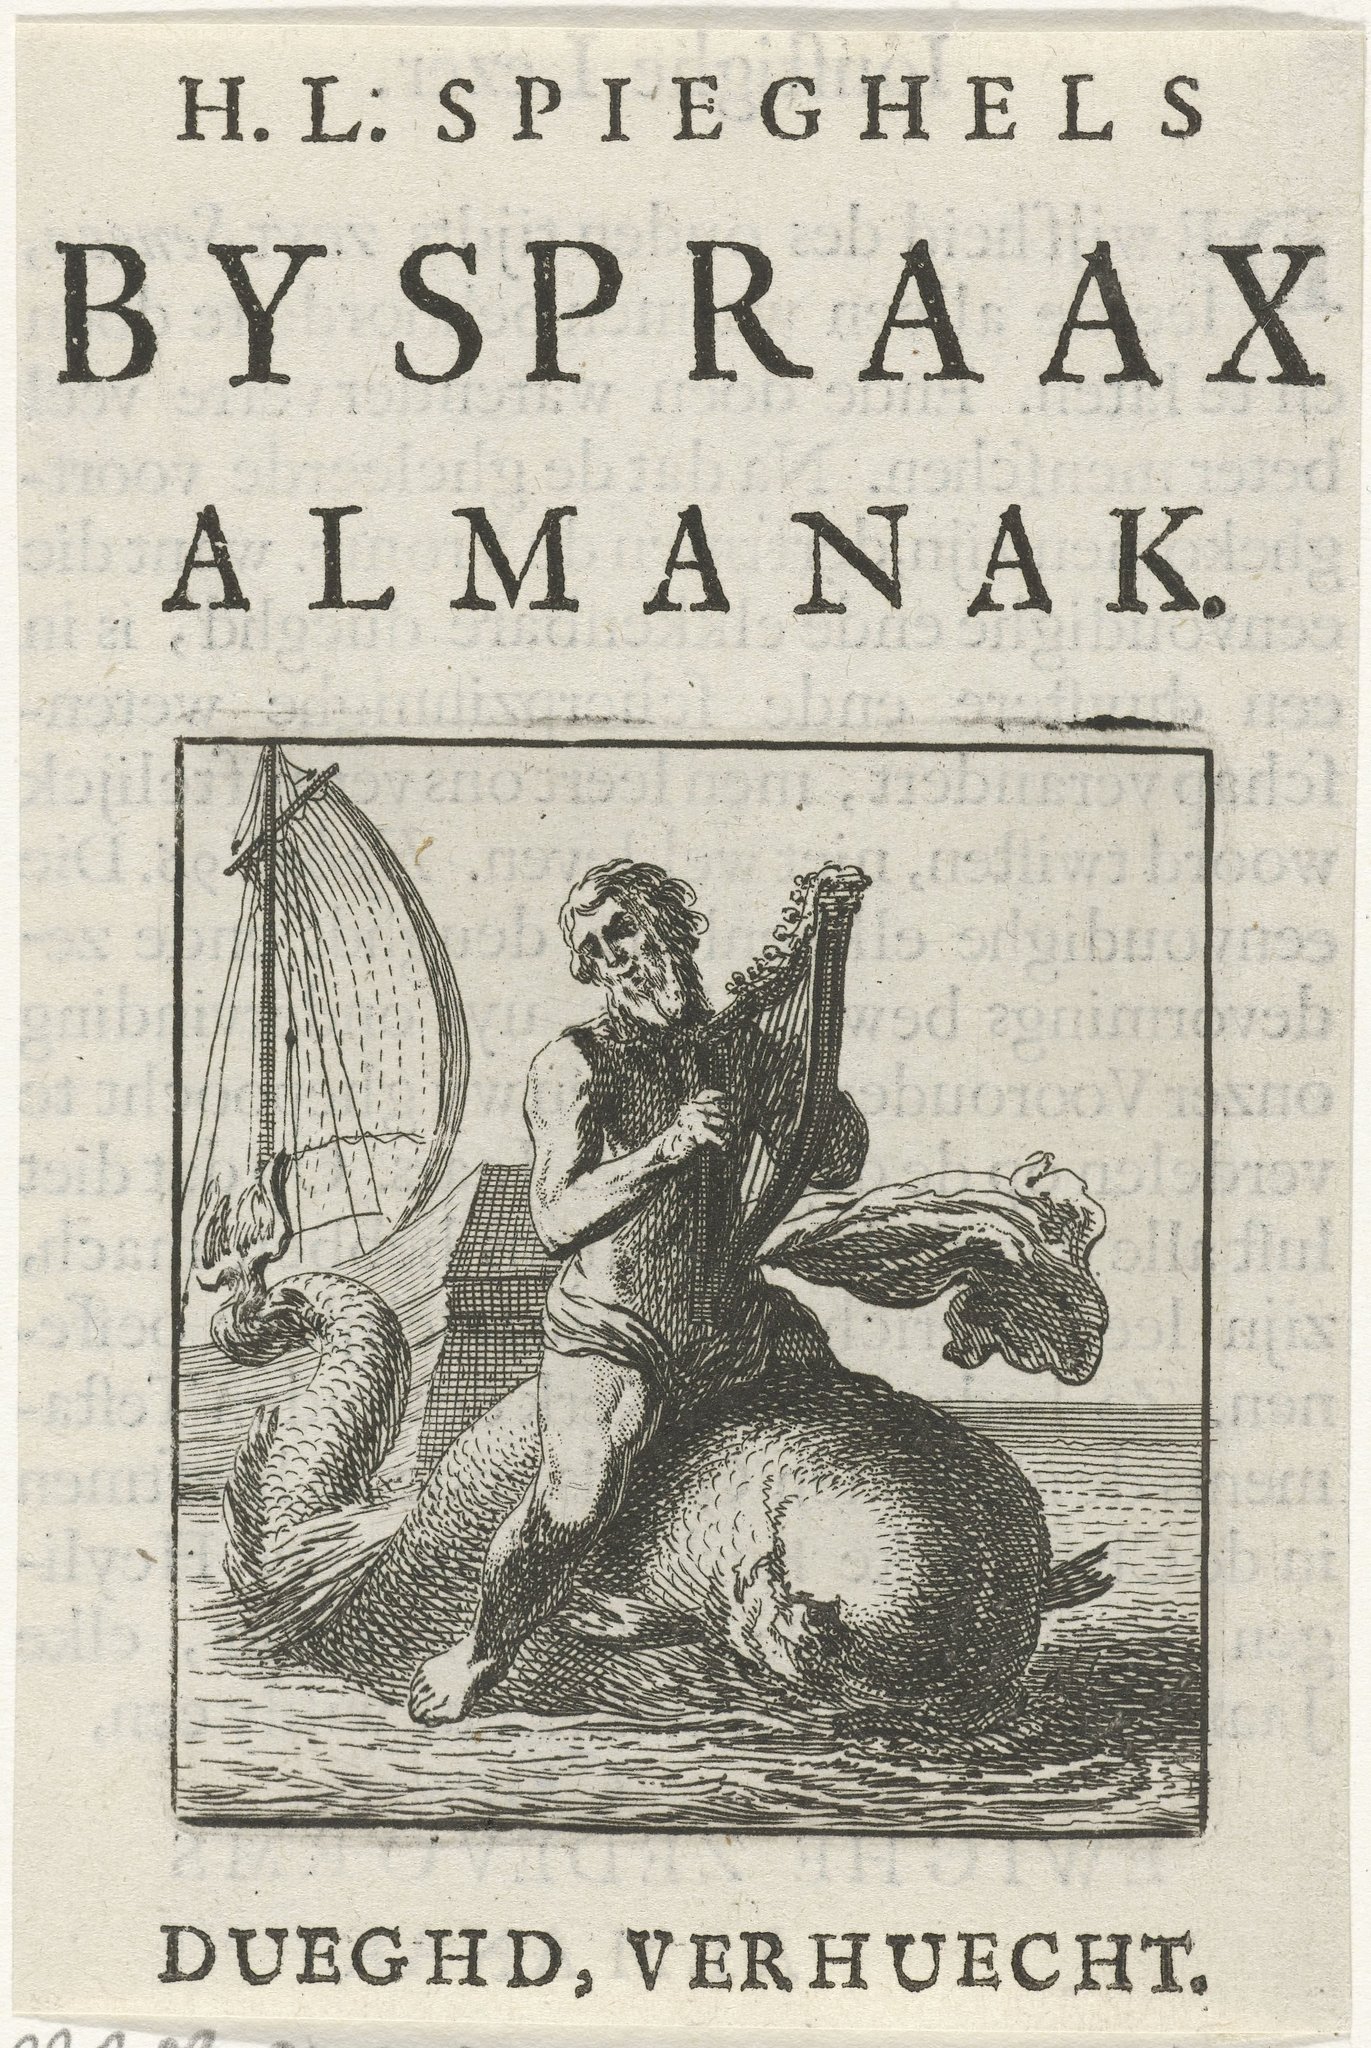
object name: print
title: Titelpagina voor: Hendrik Laurensz Spieghel, Byspraax Almanak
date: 1600-1624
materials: paper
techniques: engraving, etching, letterpress printing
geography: amsterdam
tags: arion rides on a dolphin, holding his lyre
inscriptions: collector's mark: Lugt 2228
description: Arion, gezeten op de dolfijn, bespeelt de lier. Op de achtergrond vaart het schip dat hij verliet. Onderaan in de marge een regel tekst in het Nederlands. Titelpagina voor de Byspraax-Almanak van H.L. Spieghel.